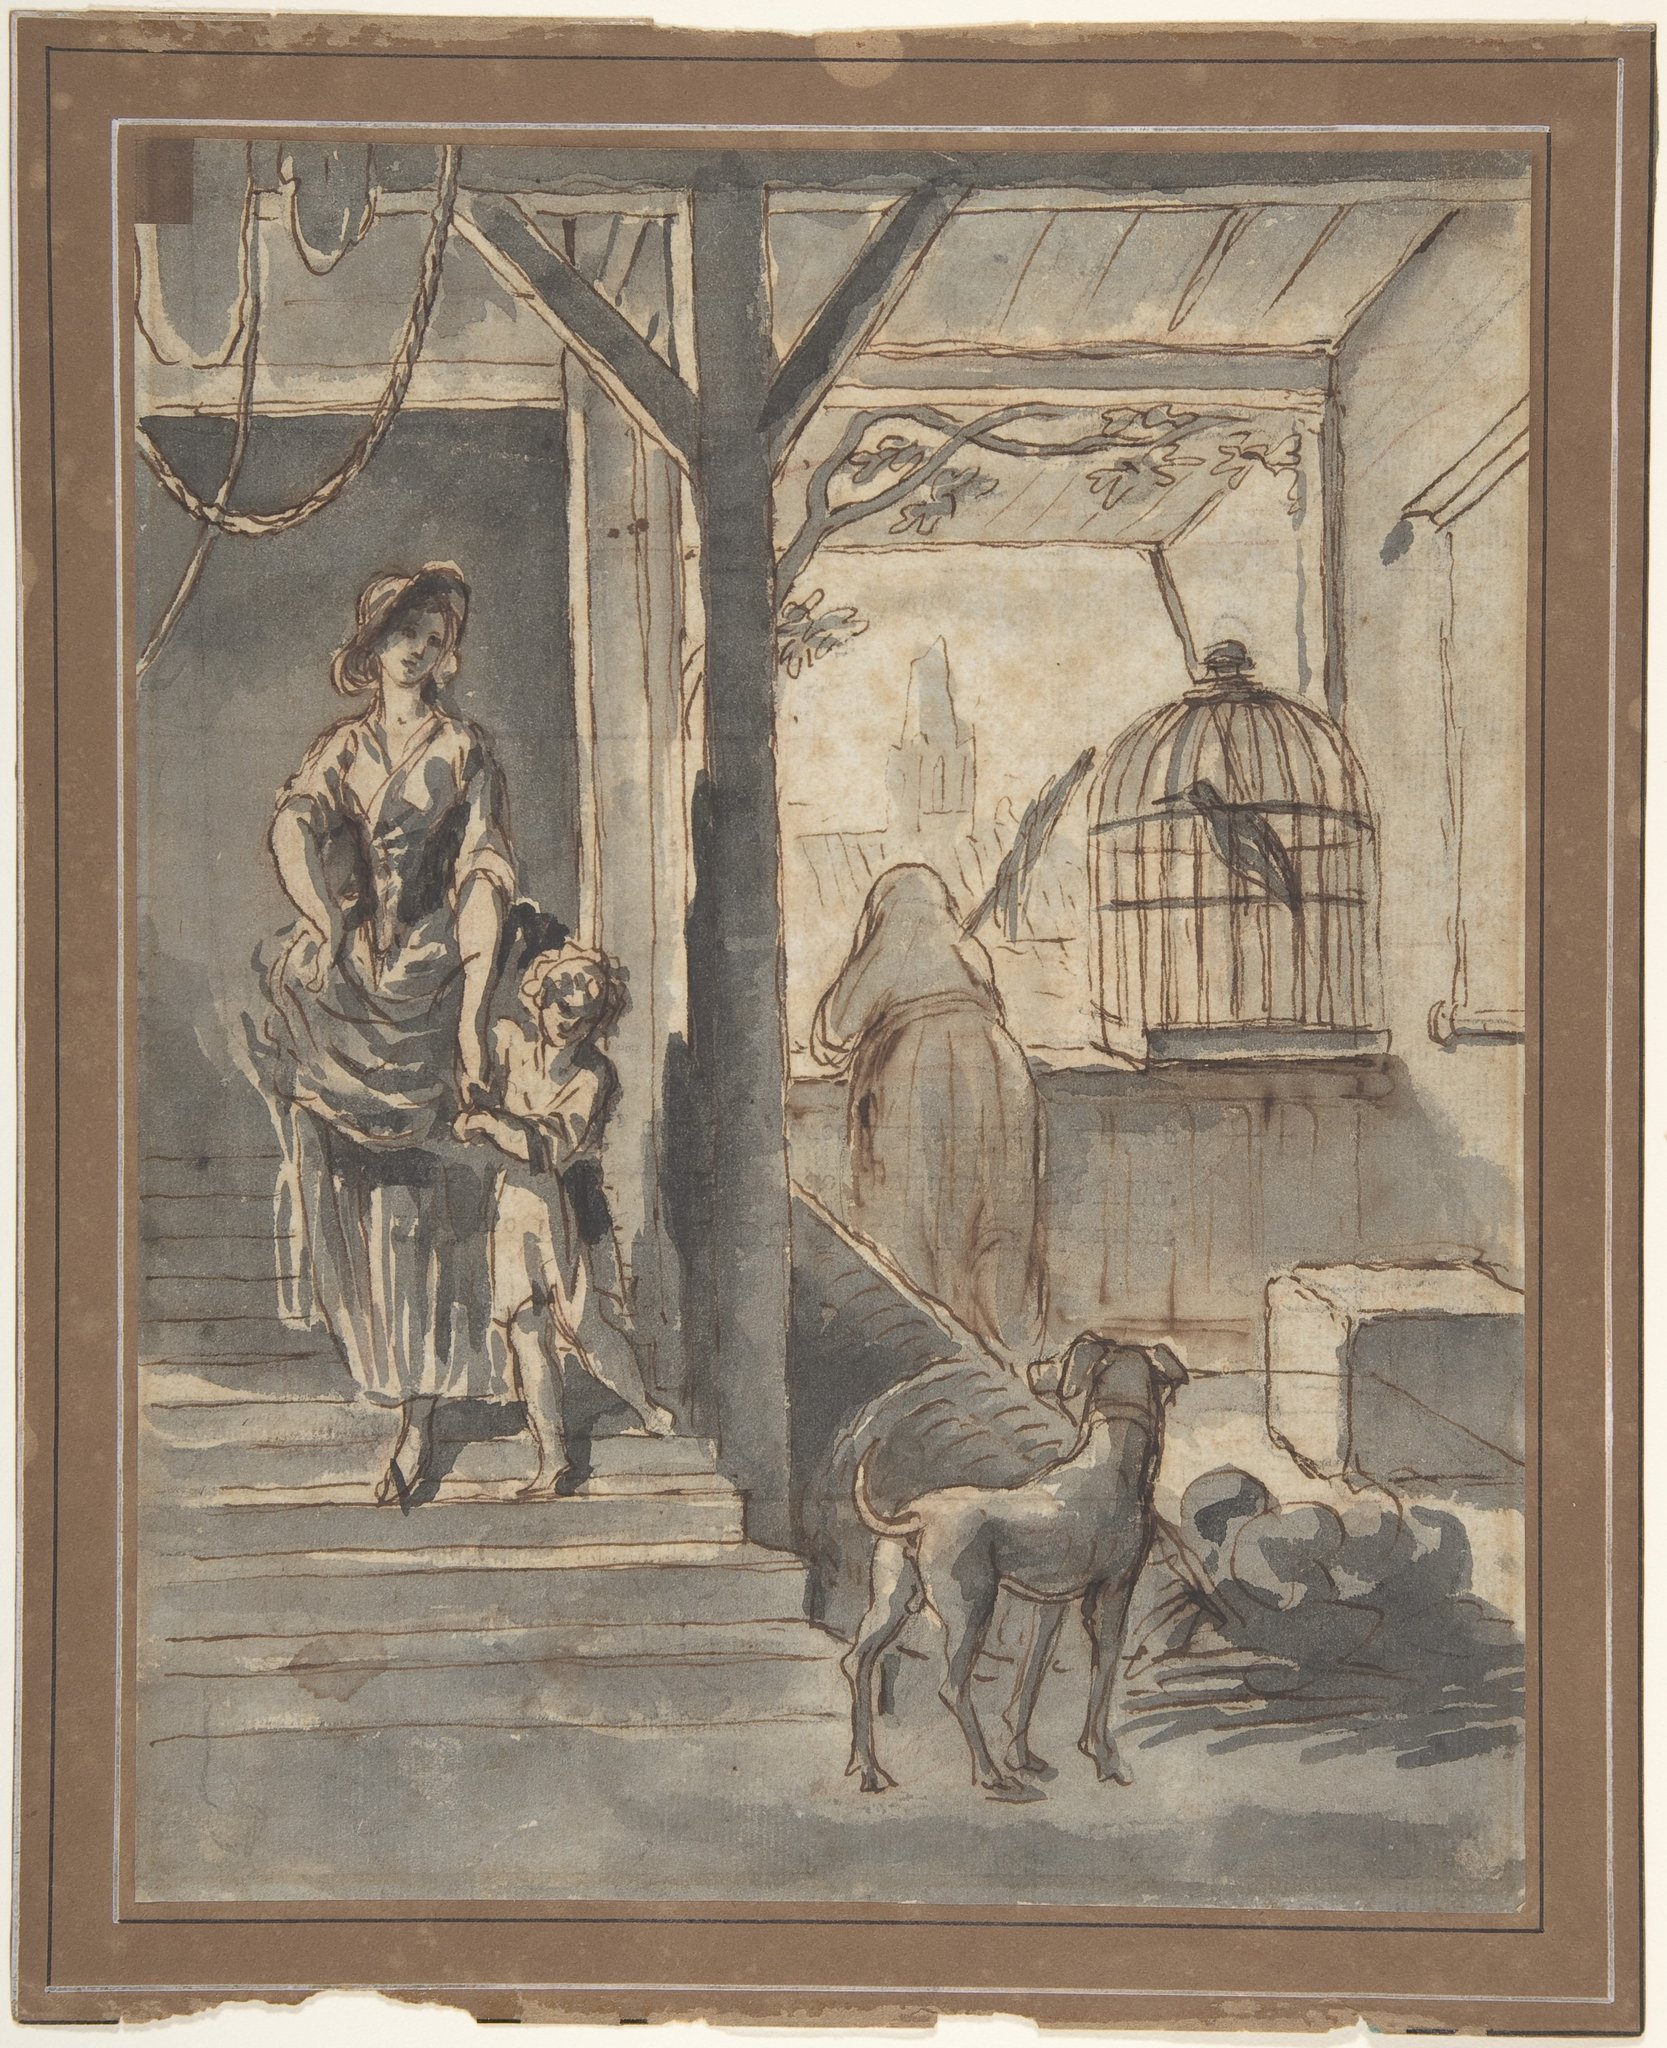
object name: drawing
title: Woman and Child on Stairs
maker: pierre lélu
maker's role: artist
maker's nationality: french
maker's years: 1741-1810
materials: chalk, ink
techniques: brush, pen, drawing, wash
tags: birds,girls,women,dogs